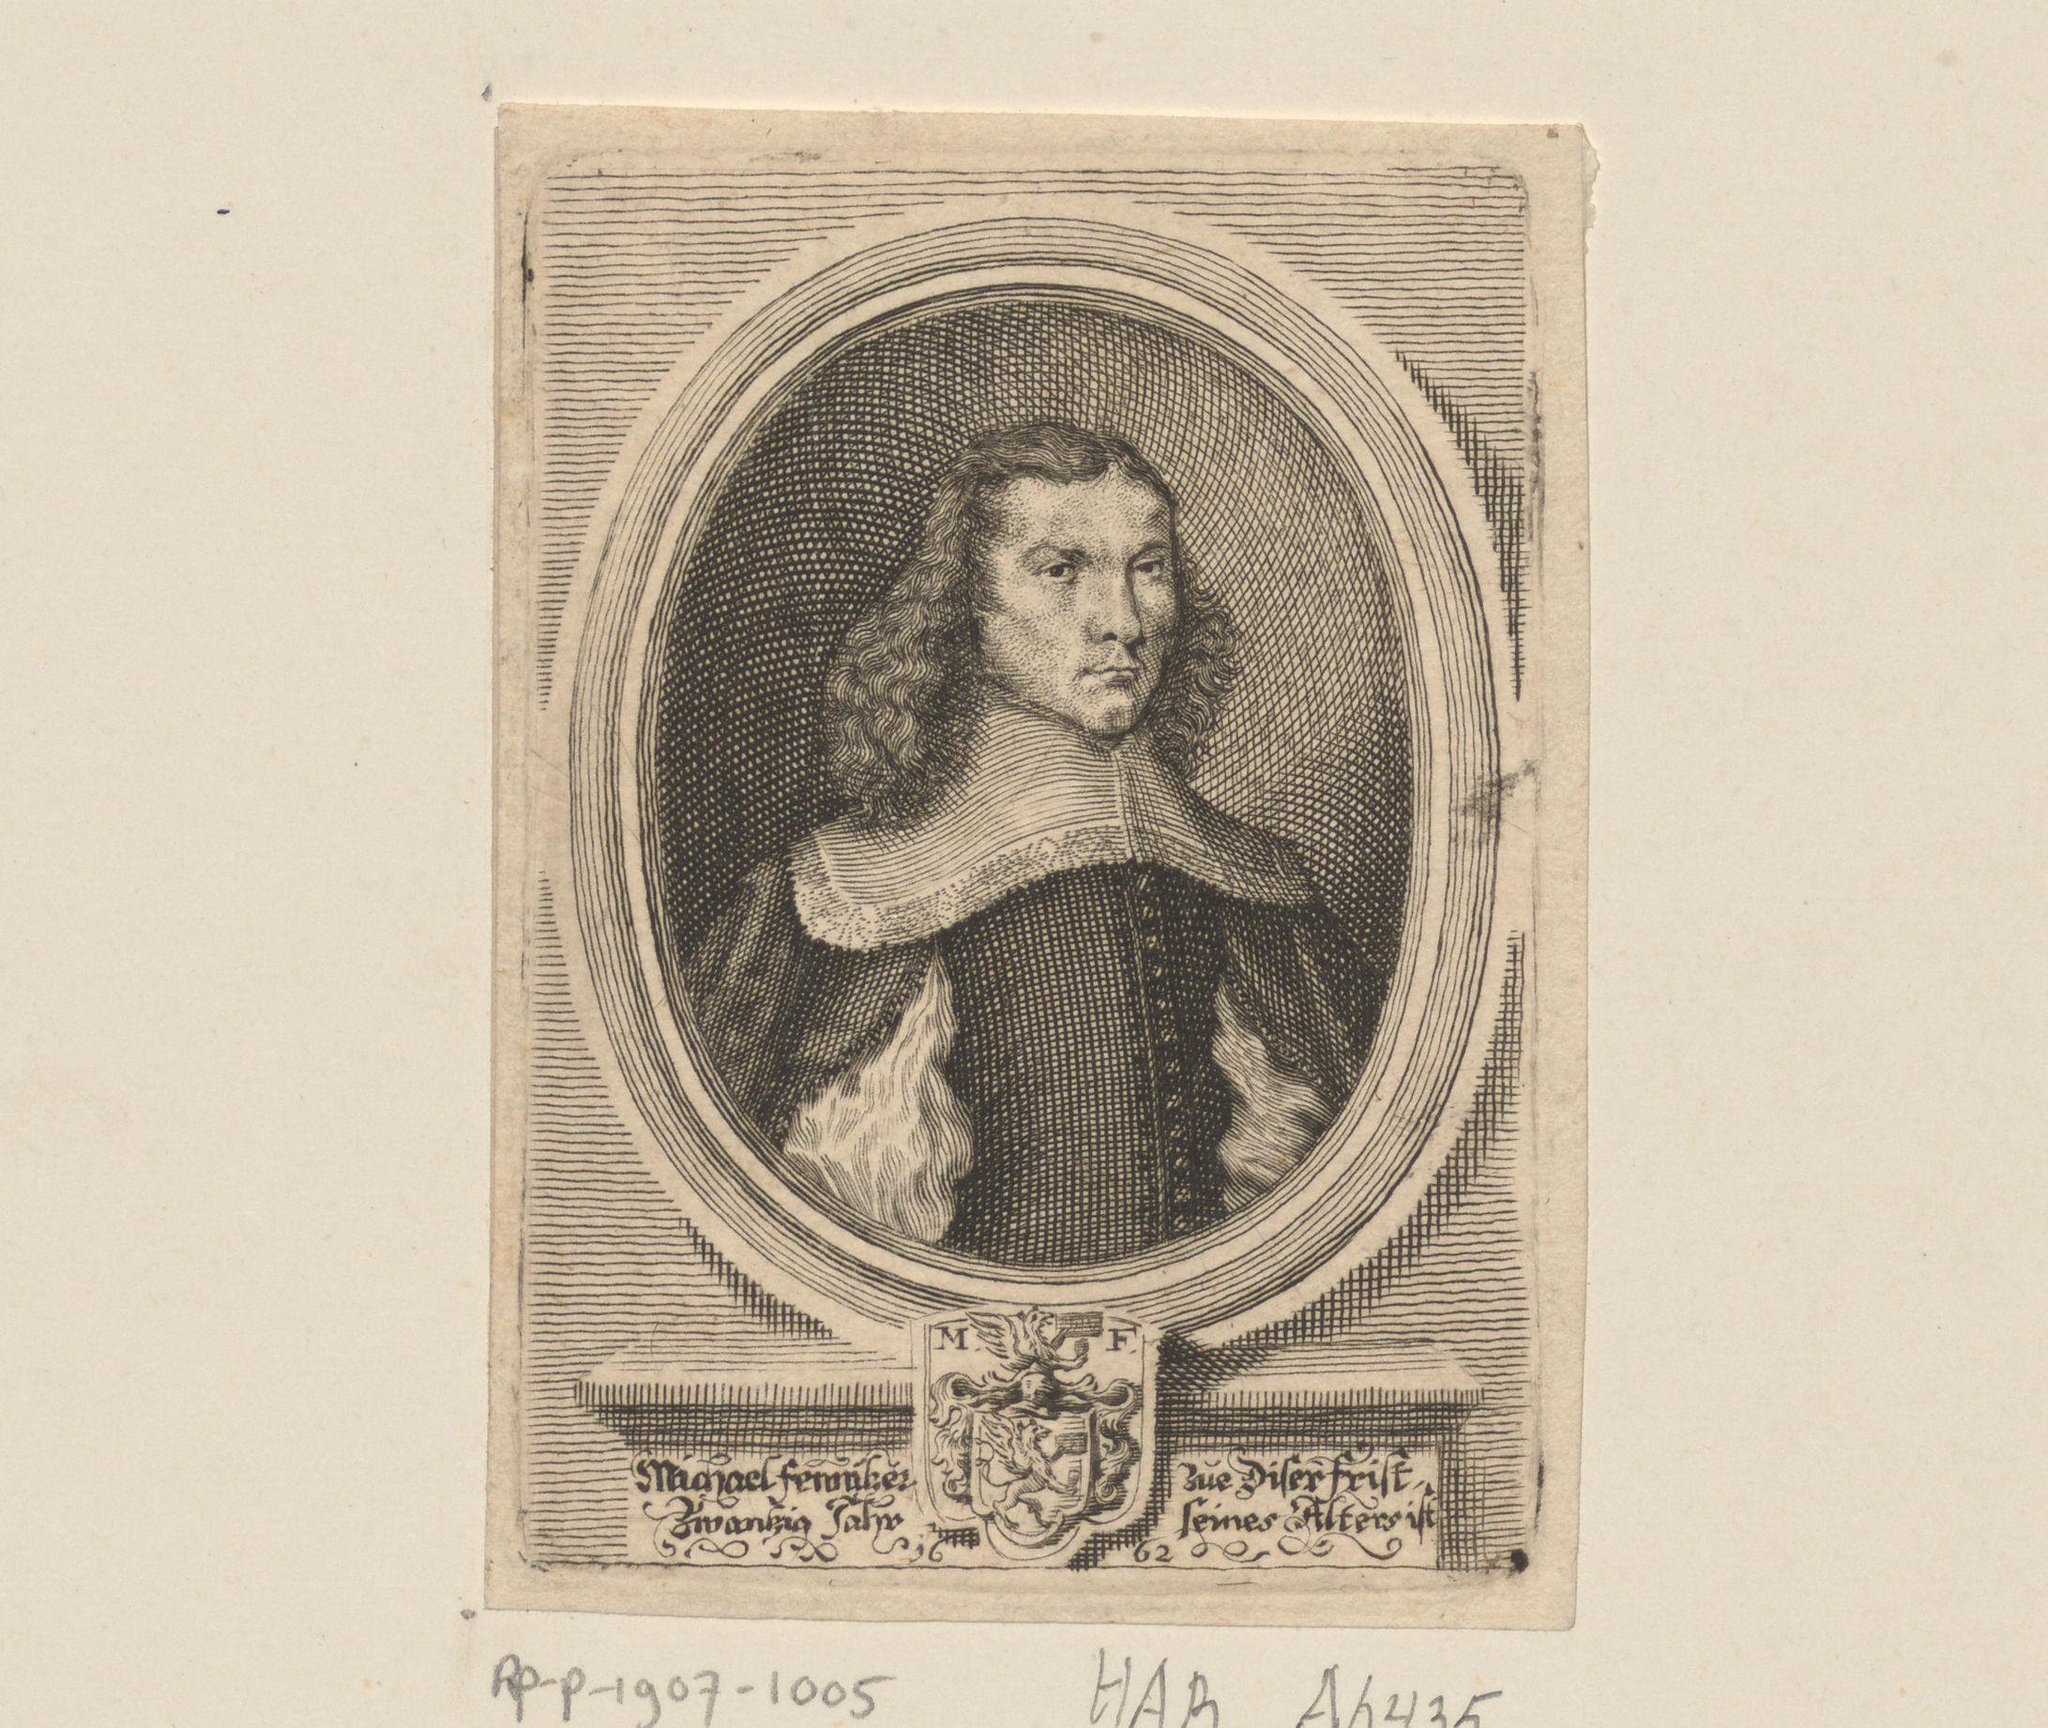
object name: print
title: Portret van Michael Fennitzer op 20-jarige leeftijd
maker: Anonymous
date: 1662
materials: paper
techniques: engraving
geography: germany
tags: print maker, printer, michael fennitzer, historical persons, portrait, self-portrait of graphic artist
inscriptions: collector's mark: Lugt 2228